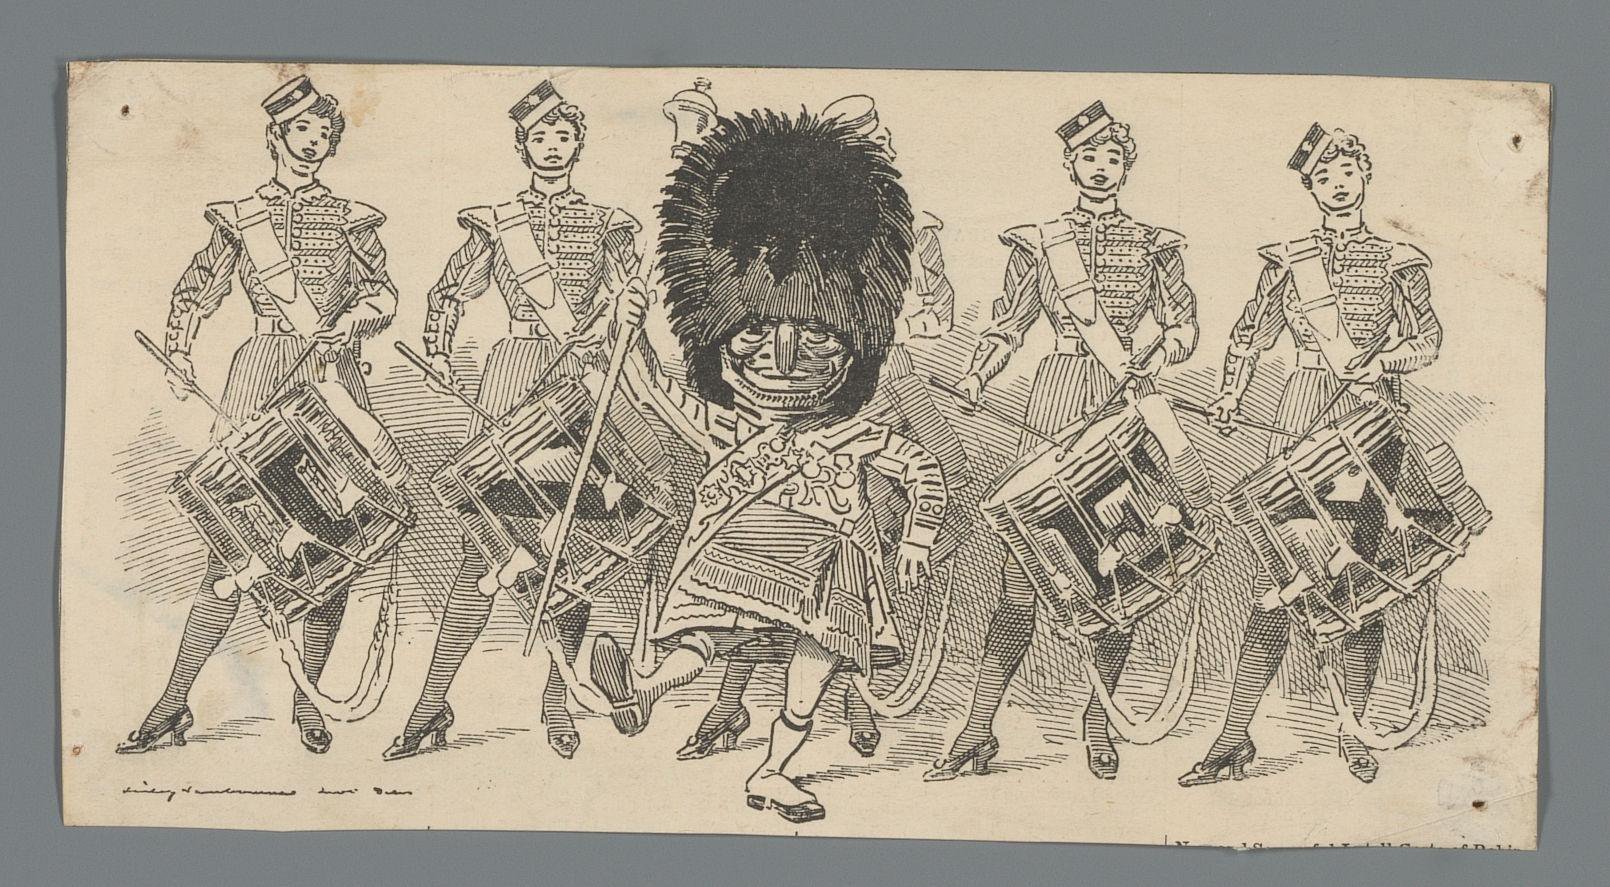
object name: print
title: Vignet uit Punch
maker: edward linley sambourne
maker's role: draughtsman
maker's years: 1844-1910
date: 1894-1904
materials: paper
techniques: line block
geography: england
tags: military band, political caricatures and satires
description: Mr. Punch als tambour-maître of tamboer-majoor. Vignet uit het Engelse satirische tijdschrift Punch, ca. 1894-1904.